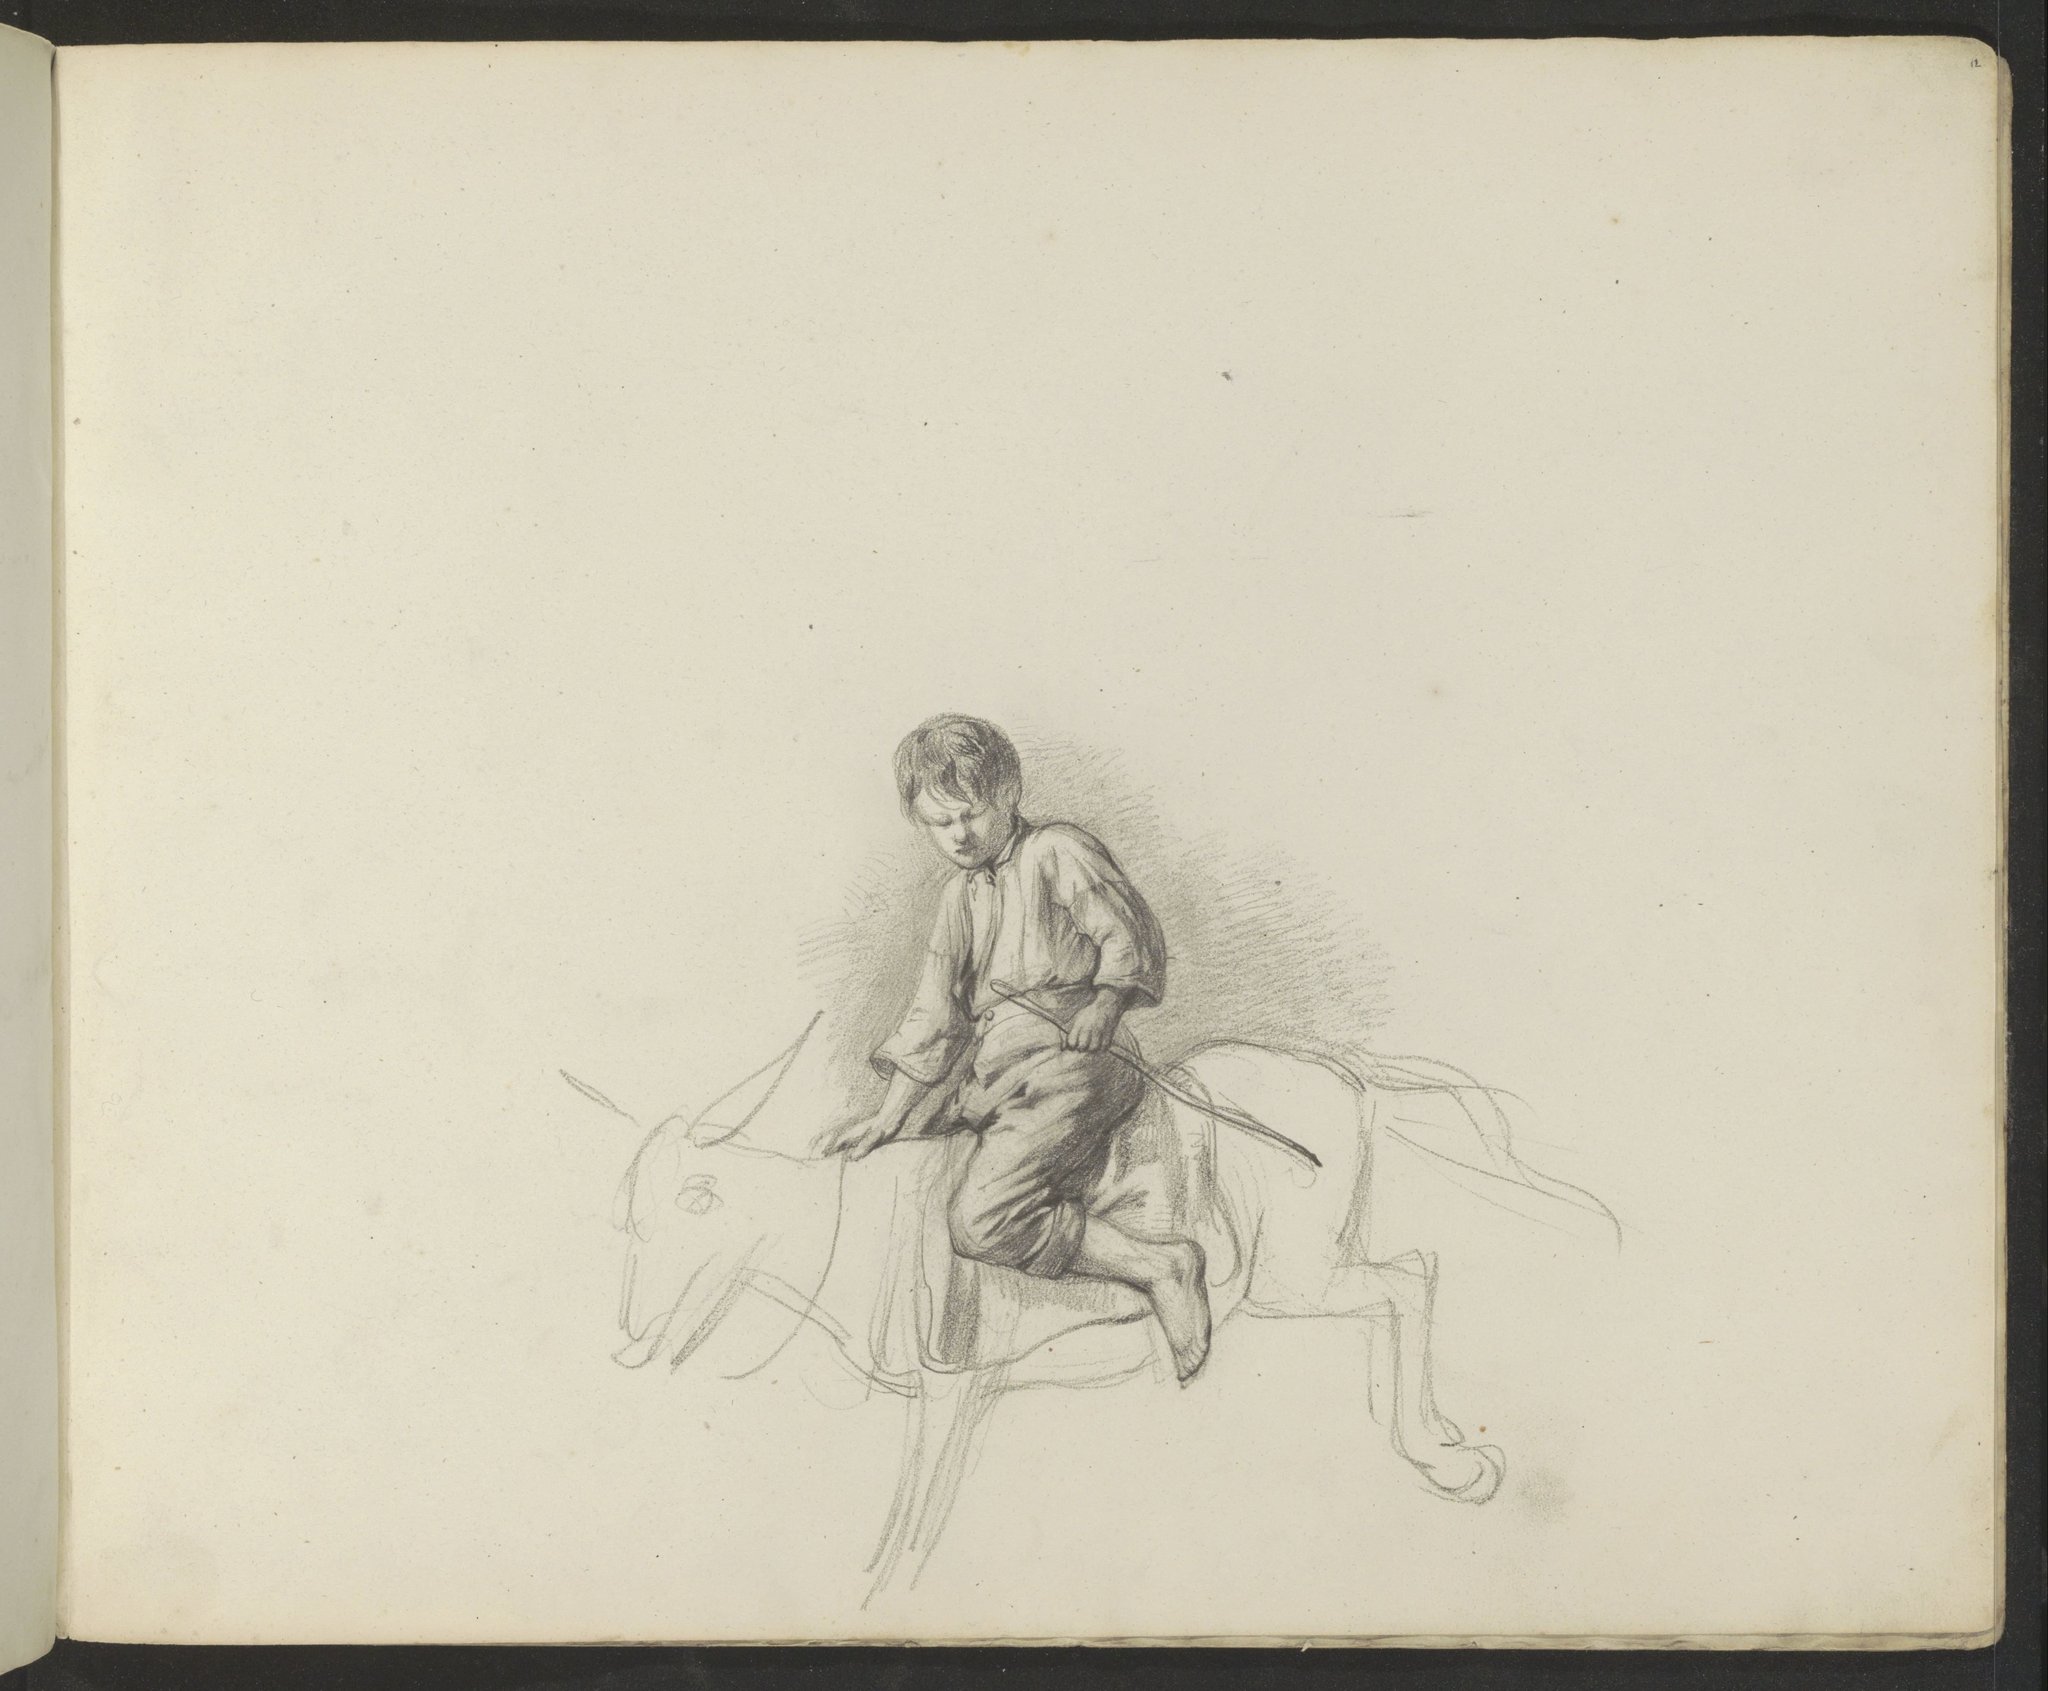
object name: sketchbook leaf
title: Jongen met stok op een ezel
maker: Anonymous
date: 1800-1899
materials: chalk, paper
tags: riding a horse, ass, or mule; rider, horseman, boy (child between toddler and youth)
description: Blad 12 recto uit een schetsboek met 13 bladen.